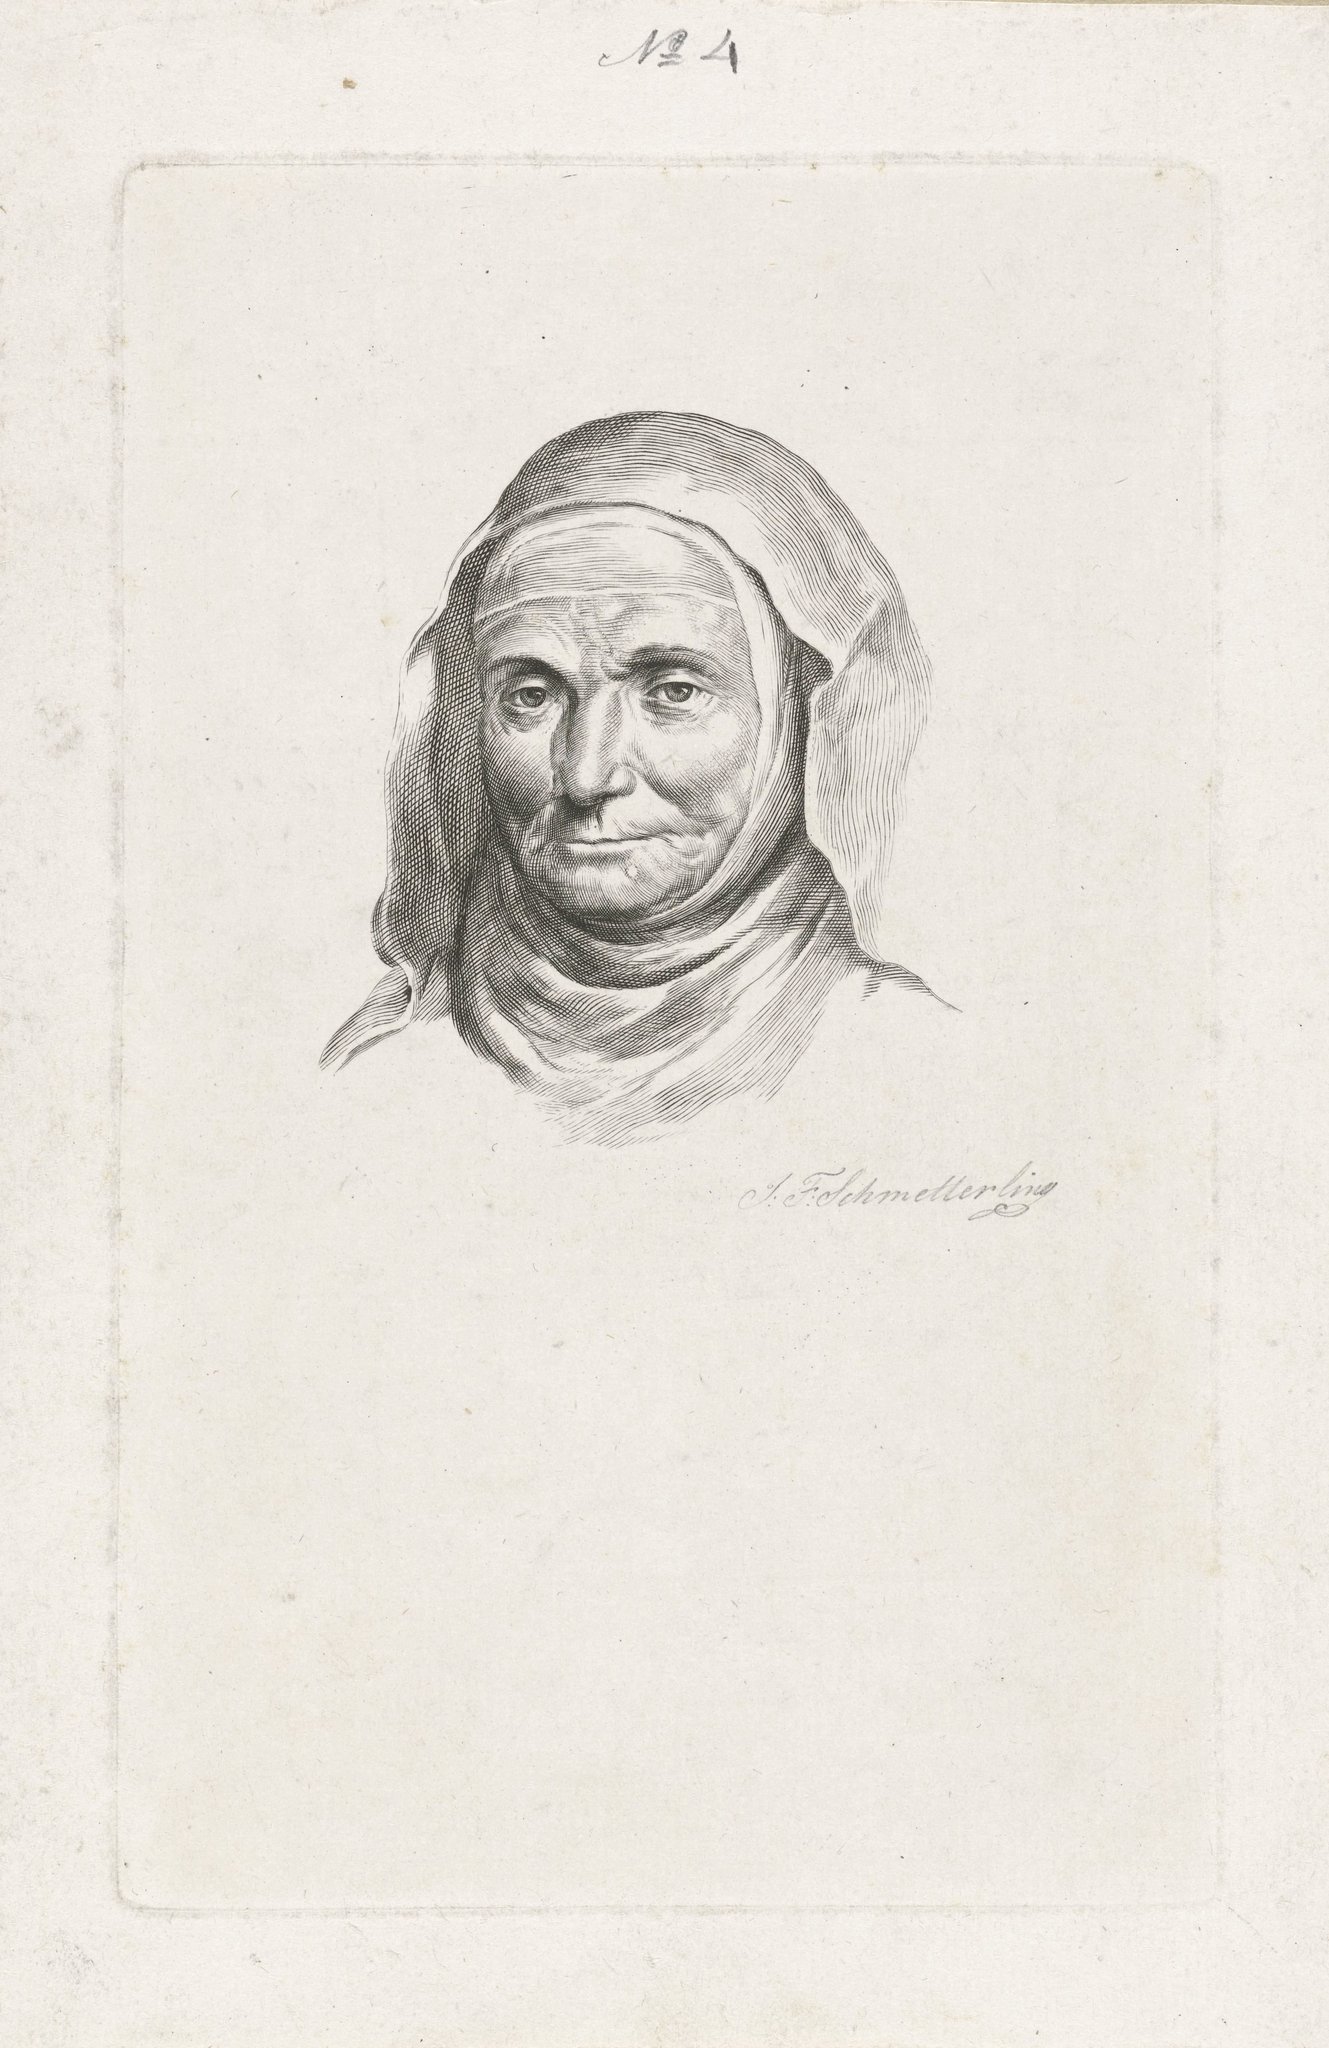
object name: print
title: Kop van een oude vrouw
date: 1825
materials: paper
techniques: engraving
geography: netherlands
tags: old woman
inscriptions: inscription: ‘Ge Graveert naar C. Bloemaert / 1825’, inscription: ‘N4 J:F: Schmetterling’